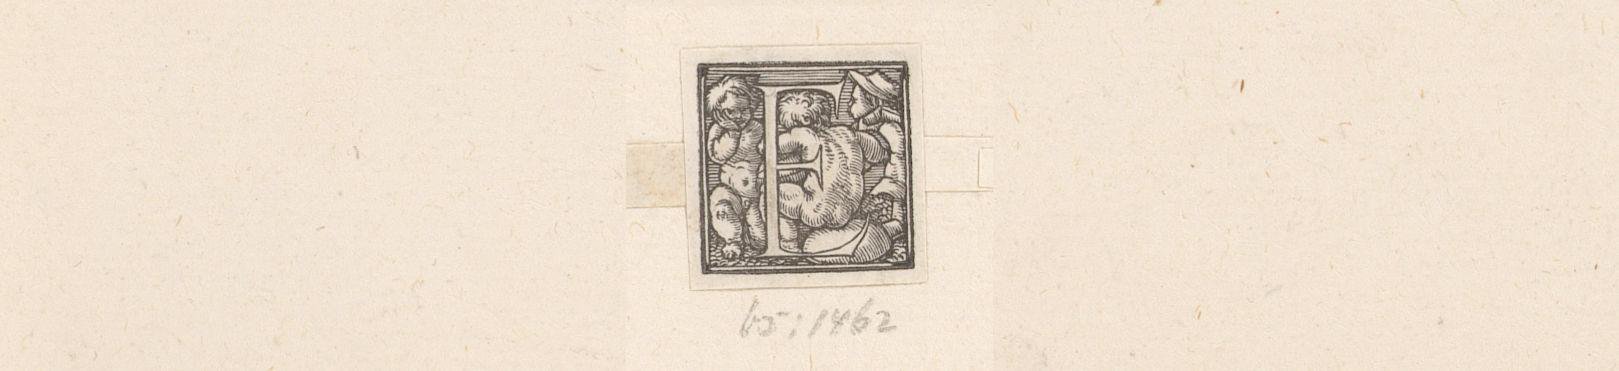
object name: print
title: Initiaal E met drie zittende kinderen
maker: hans lützelburger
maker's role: print maker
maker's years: -1526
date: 1522-1526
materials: paper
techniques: woodcut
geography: basel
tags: initial, cupids: 'amores', 'amoretti', 'putti'